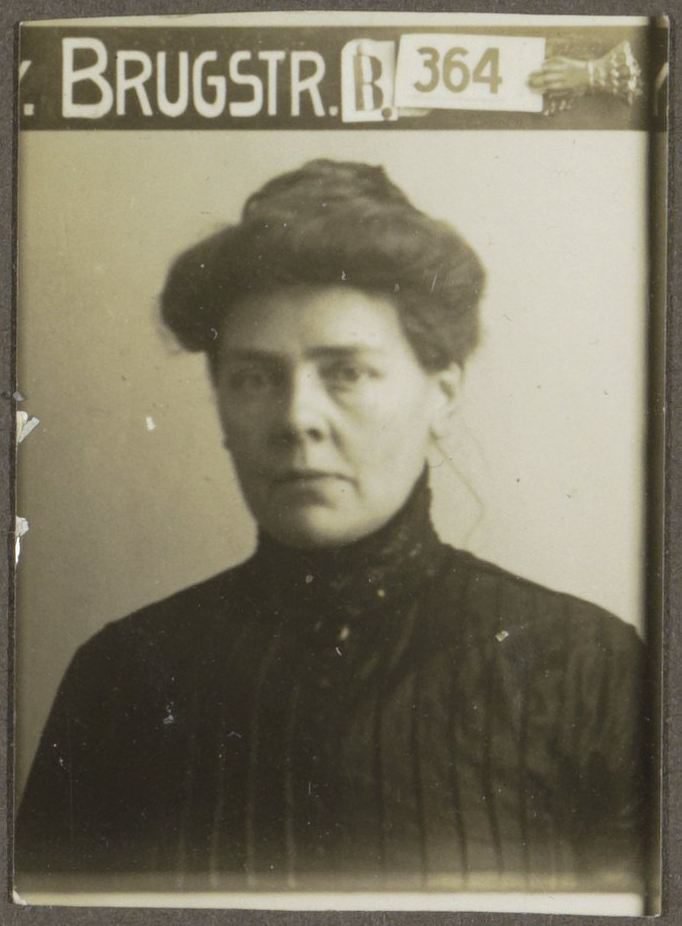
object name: photograph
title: Portret van een vrouw met opgestoken haar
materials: paper, cardboard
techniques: gelatin silver print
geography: groningen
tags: adult woman, historical persons, head-gear: hat, netherlands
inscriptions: number: ‘B 364’, address: ‘Brugstraat 25’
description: Rechtsboven is de klem in de vorm van een hand zichtbaar, waarmee het opnamenummer werd vastgezet. Onderdeel van Fotoalbum met portretten vervaardigd door Nederlandse studio's waaronder automaatfoto's.